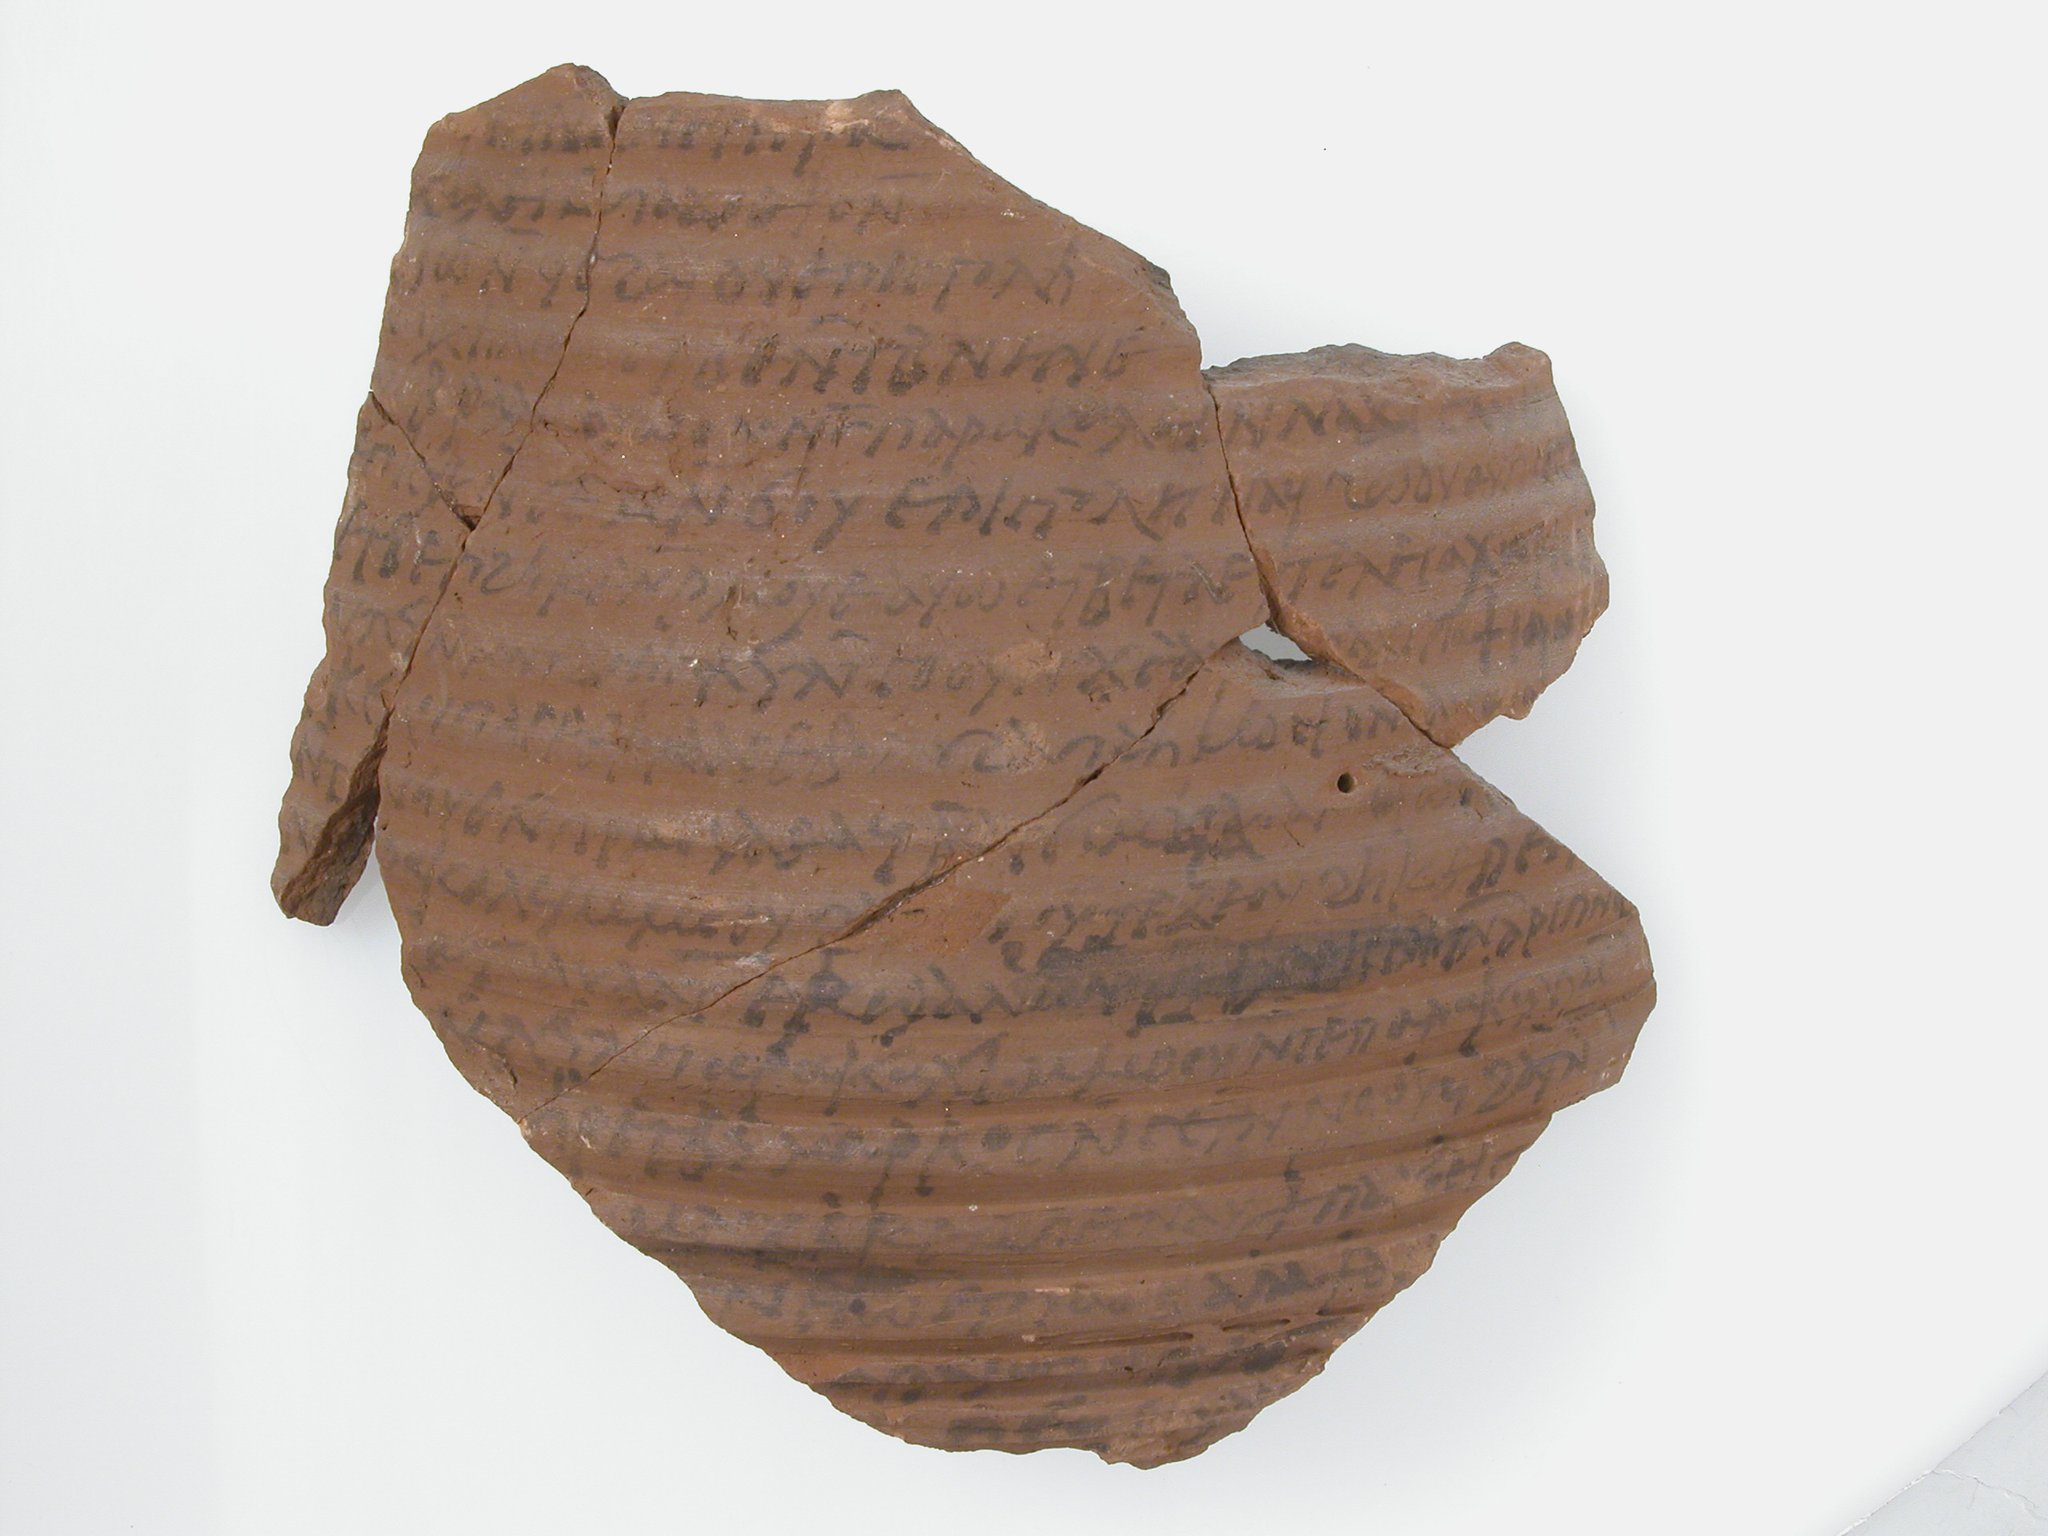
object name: ostrakon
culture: coptic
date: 601-700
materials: ink, pottery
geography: egypt